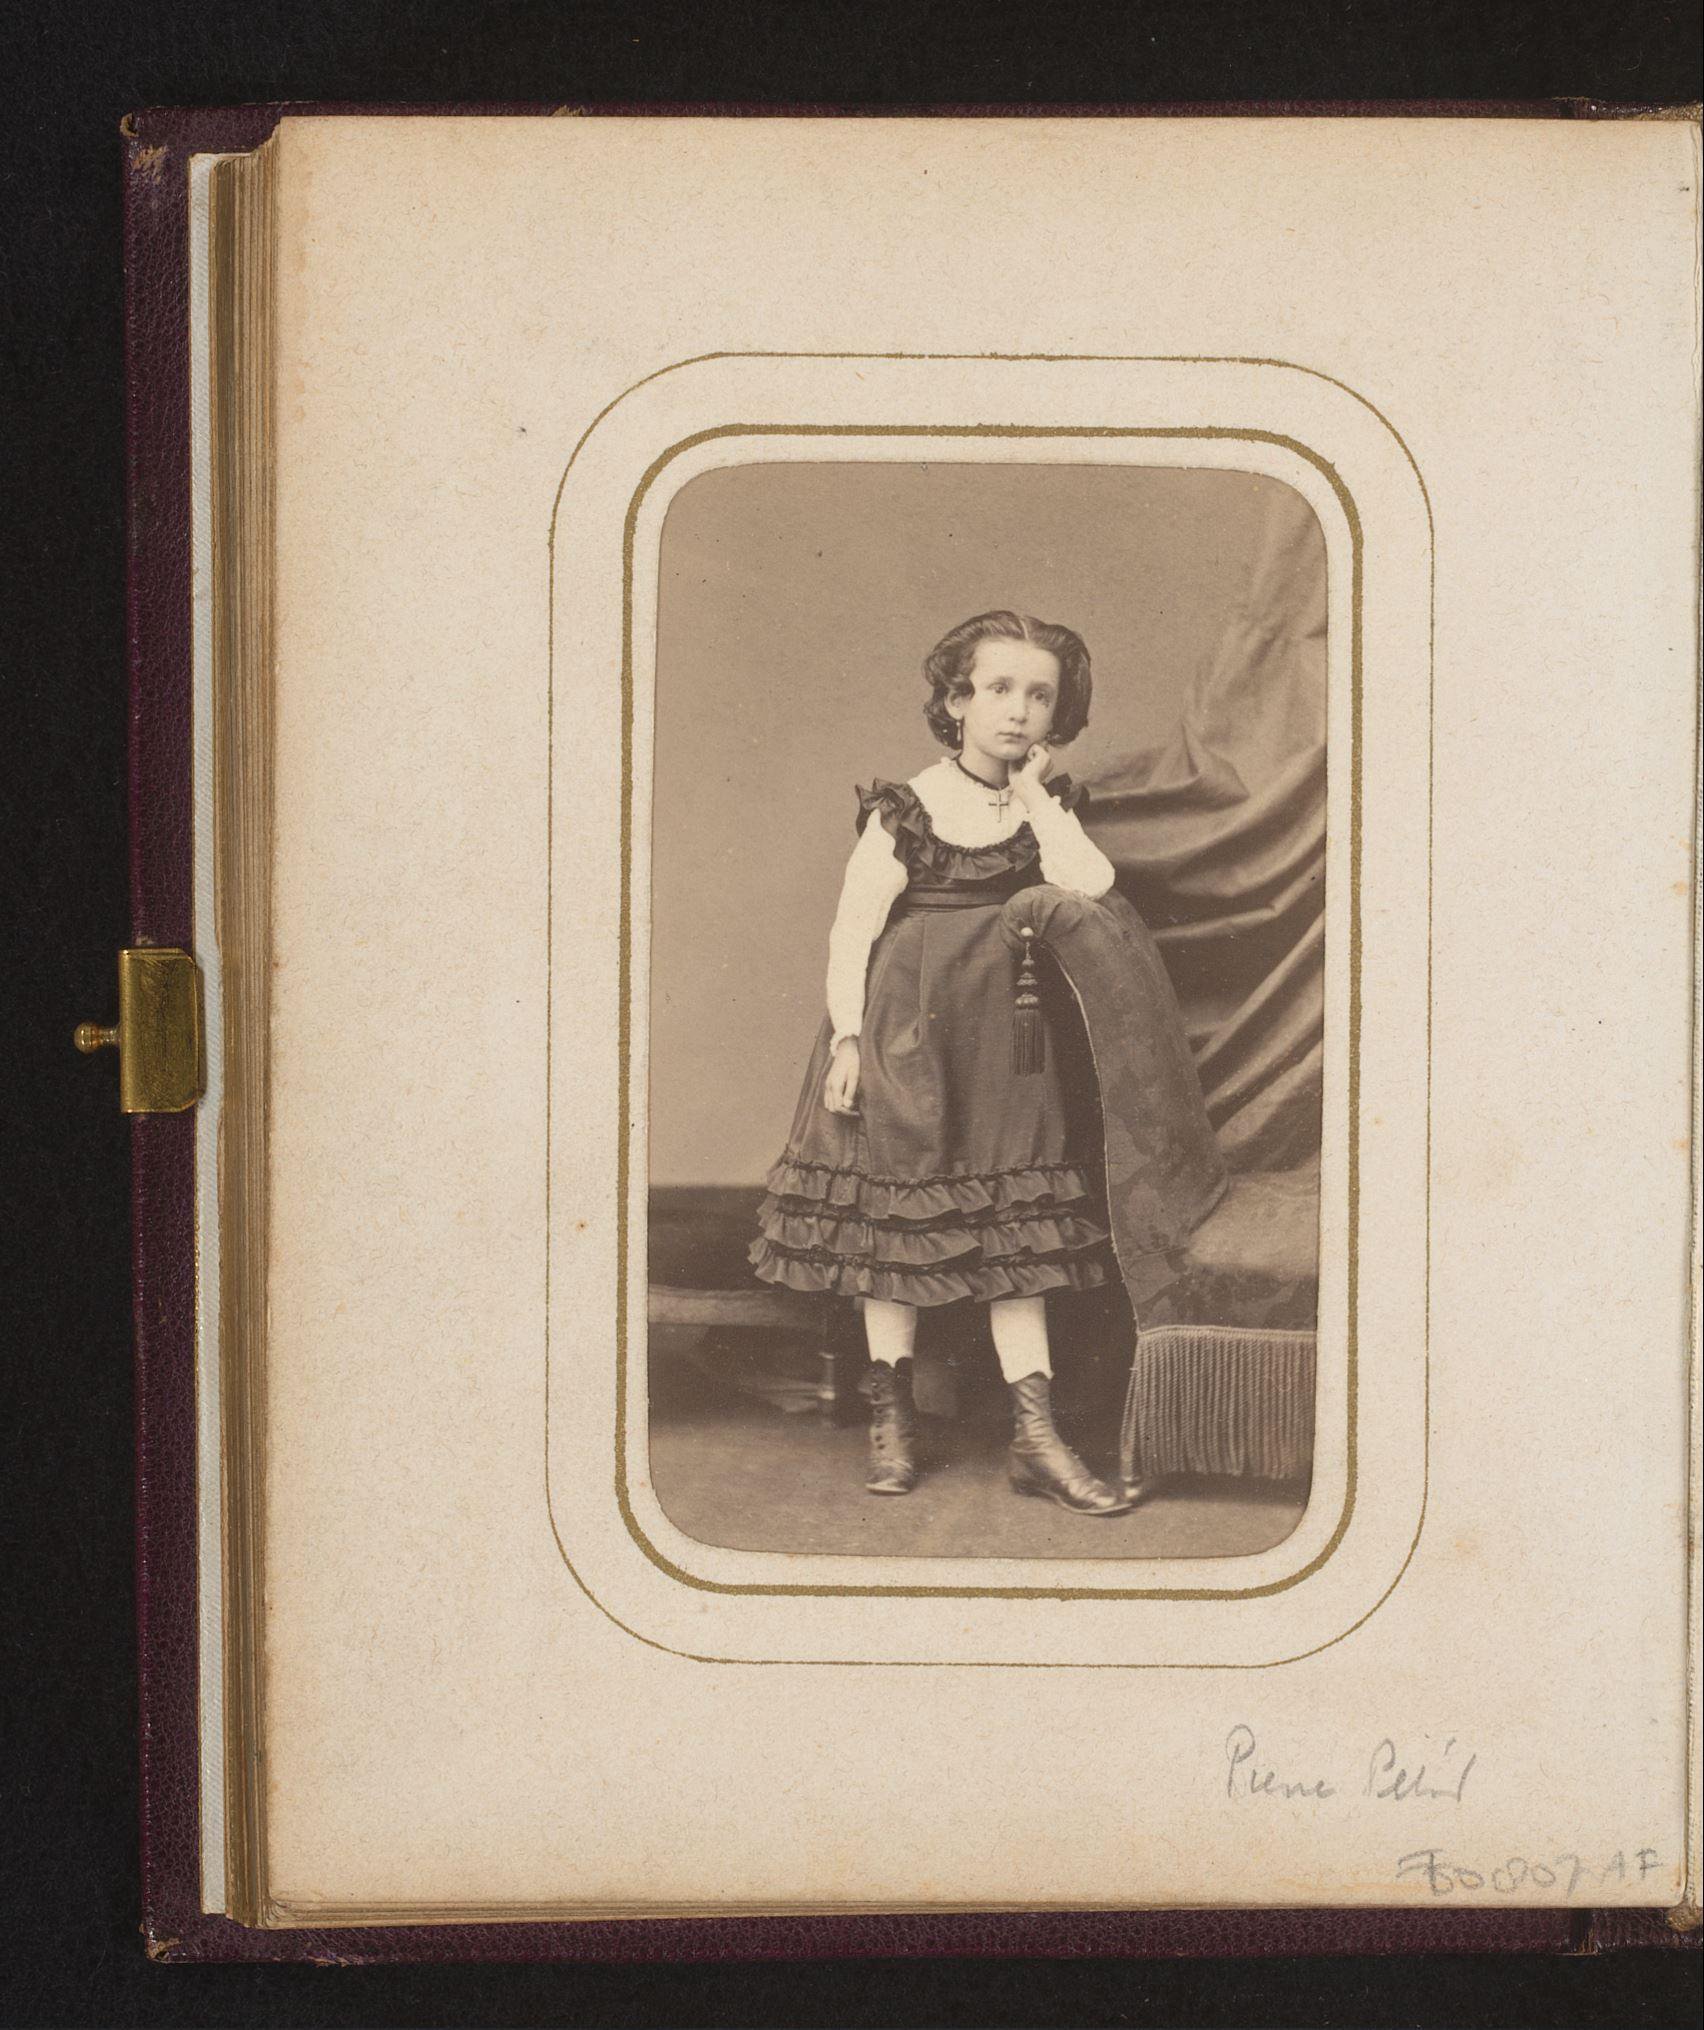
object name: album leaf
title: Portret van een meisje, leunend op de leuning van een stoel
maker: pierre petit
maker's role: fotograaf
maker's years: 1832-1909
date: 1881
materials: cardboard, photographic support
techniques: albumen print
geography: paris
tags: historical persons - bb - woman, girl (child between toddler and youth), chair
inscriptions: inscription: ‘EXPOSITION UNIVERSELLE 1867/ Pierre Petit/ PHOTOGRAPHE DE LA COMon IMPERIALE/ DU ROI DE PRUSSE/ DE L'EPISCOPAT/ DU Gd DUC DE BADE/ DES LYCÉES IMPÉRIAUX/ &.&.&.&.&./ 31, Place Cadet./ PARIS’, annotation: ‘Pierre Petit’